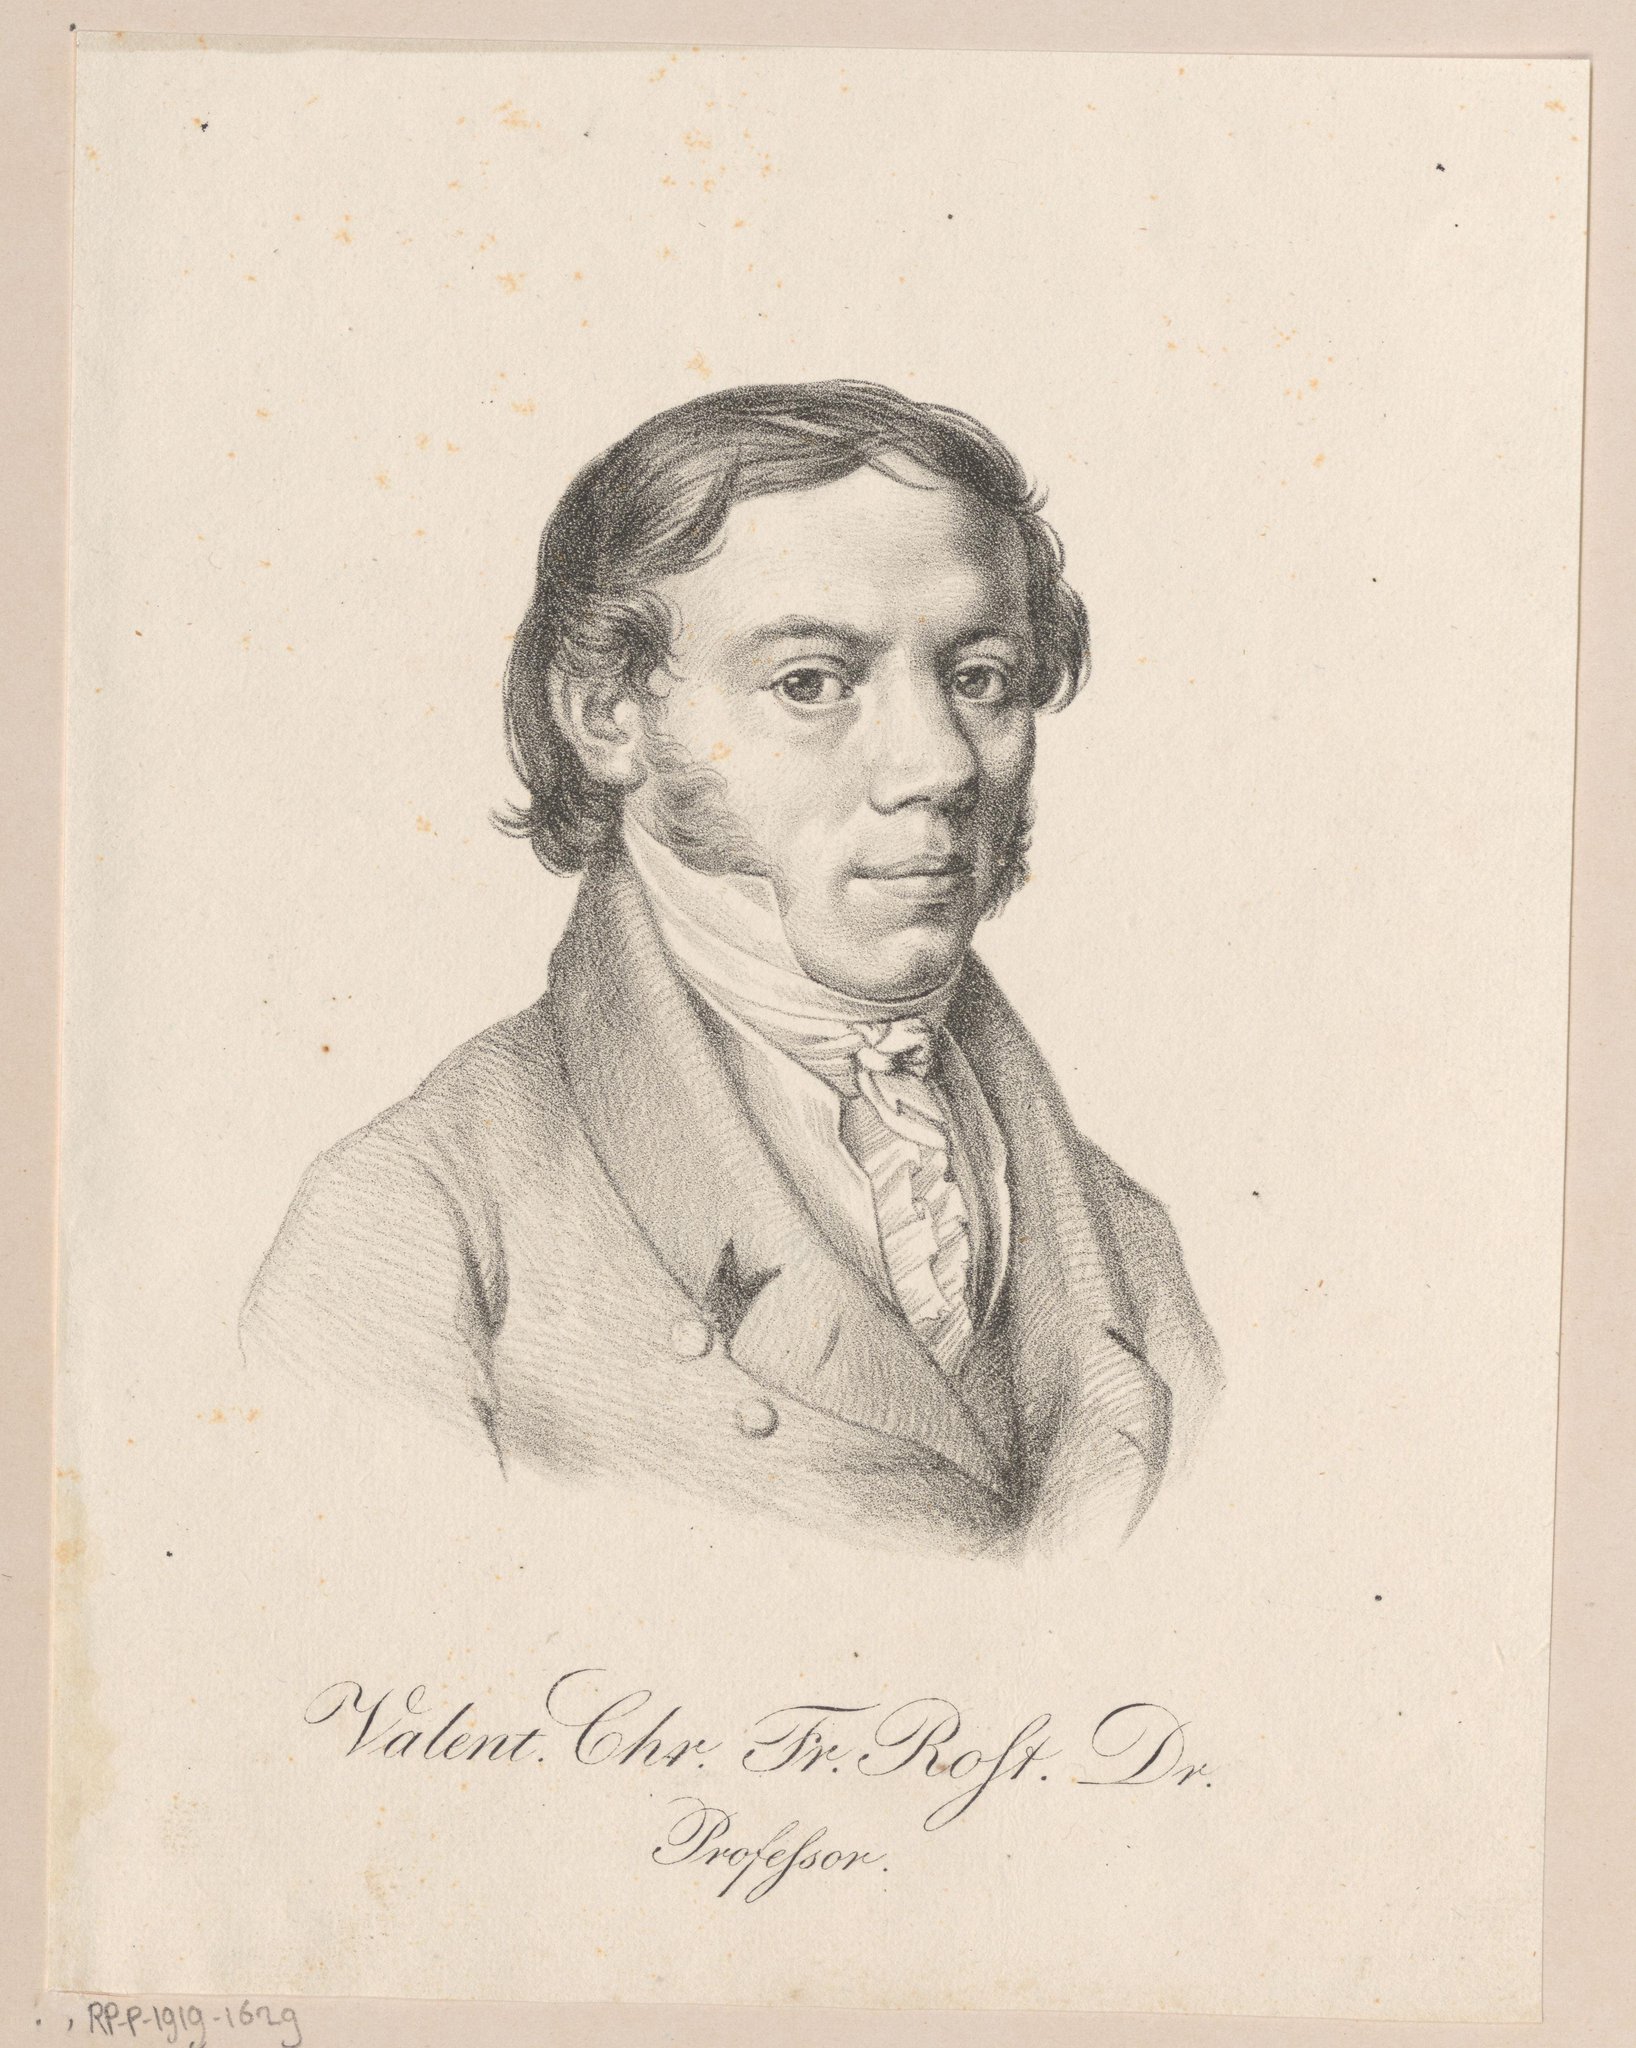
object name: print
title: Portret van Valentin Rost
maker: Anonymous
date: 1810-1872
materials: paper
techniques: lithograph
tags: historical persons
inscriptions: collector's mark: Lugt 2228